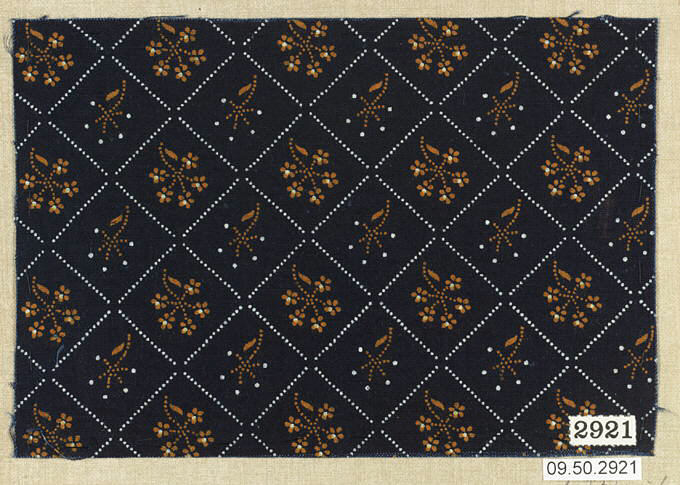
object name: piece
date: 1801-1900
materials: cotton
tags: flowers